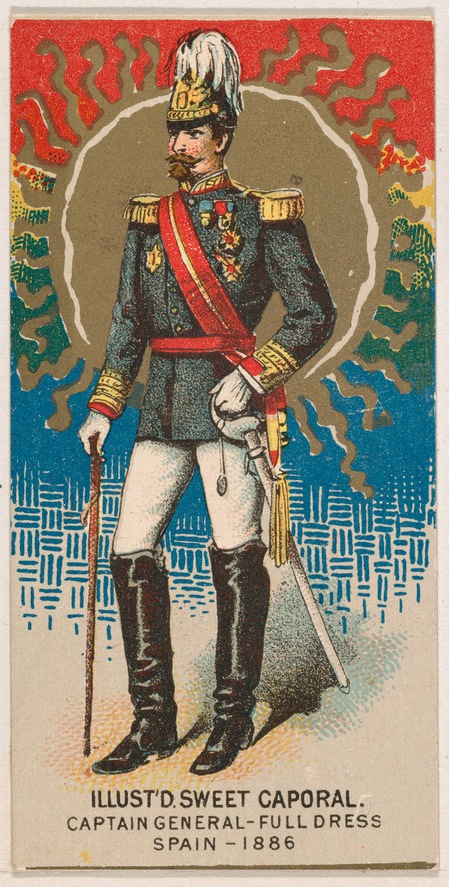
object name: print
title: Full Dress, Captain General, Spain, 1886, from the Military Series (N224) issued by Kinney Tobacco Company to promote Sweet Caporal Cigarettes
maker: kinney brothers tobacco company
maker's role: publisher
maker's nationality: american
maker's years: 1869-2011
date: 1888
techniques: color lithograph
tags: soldiers,swords,men